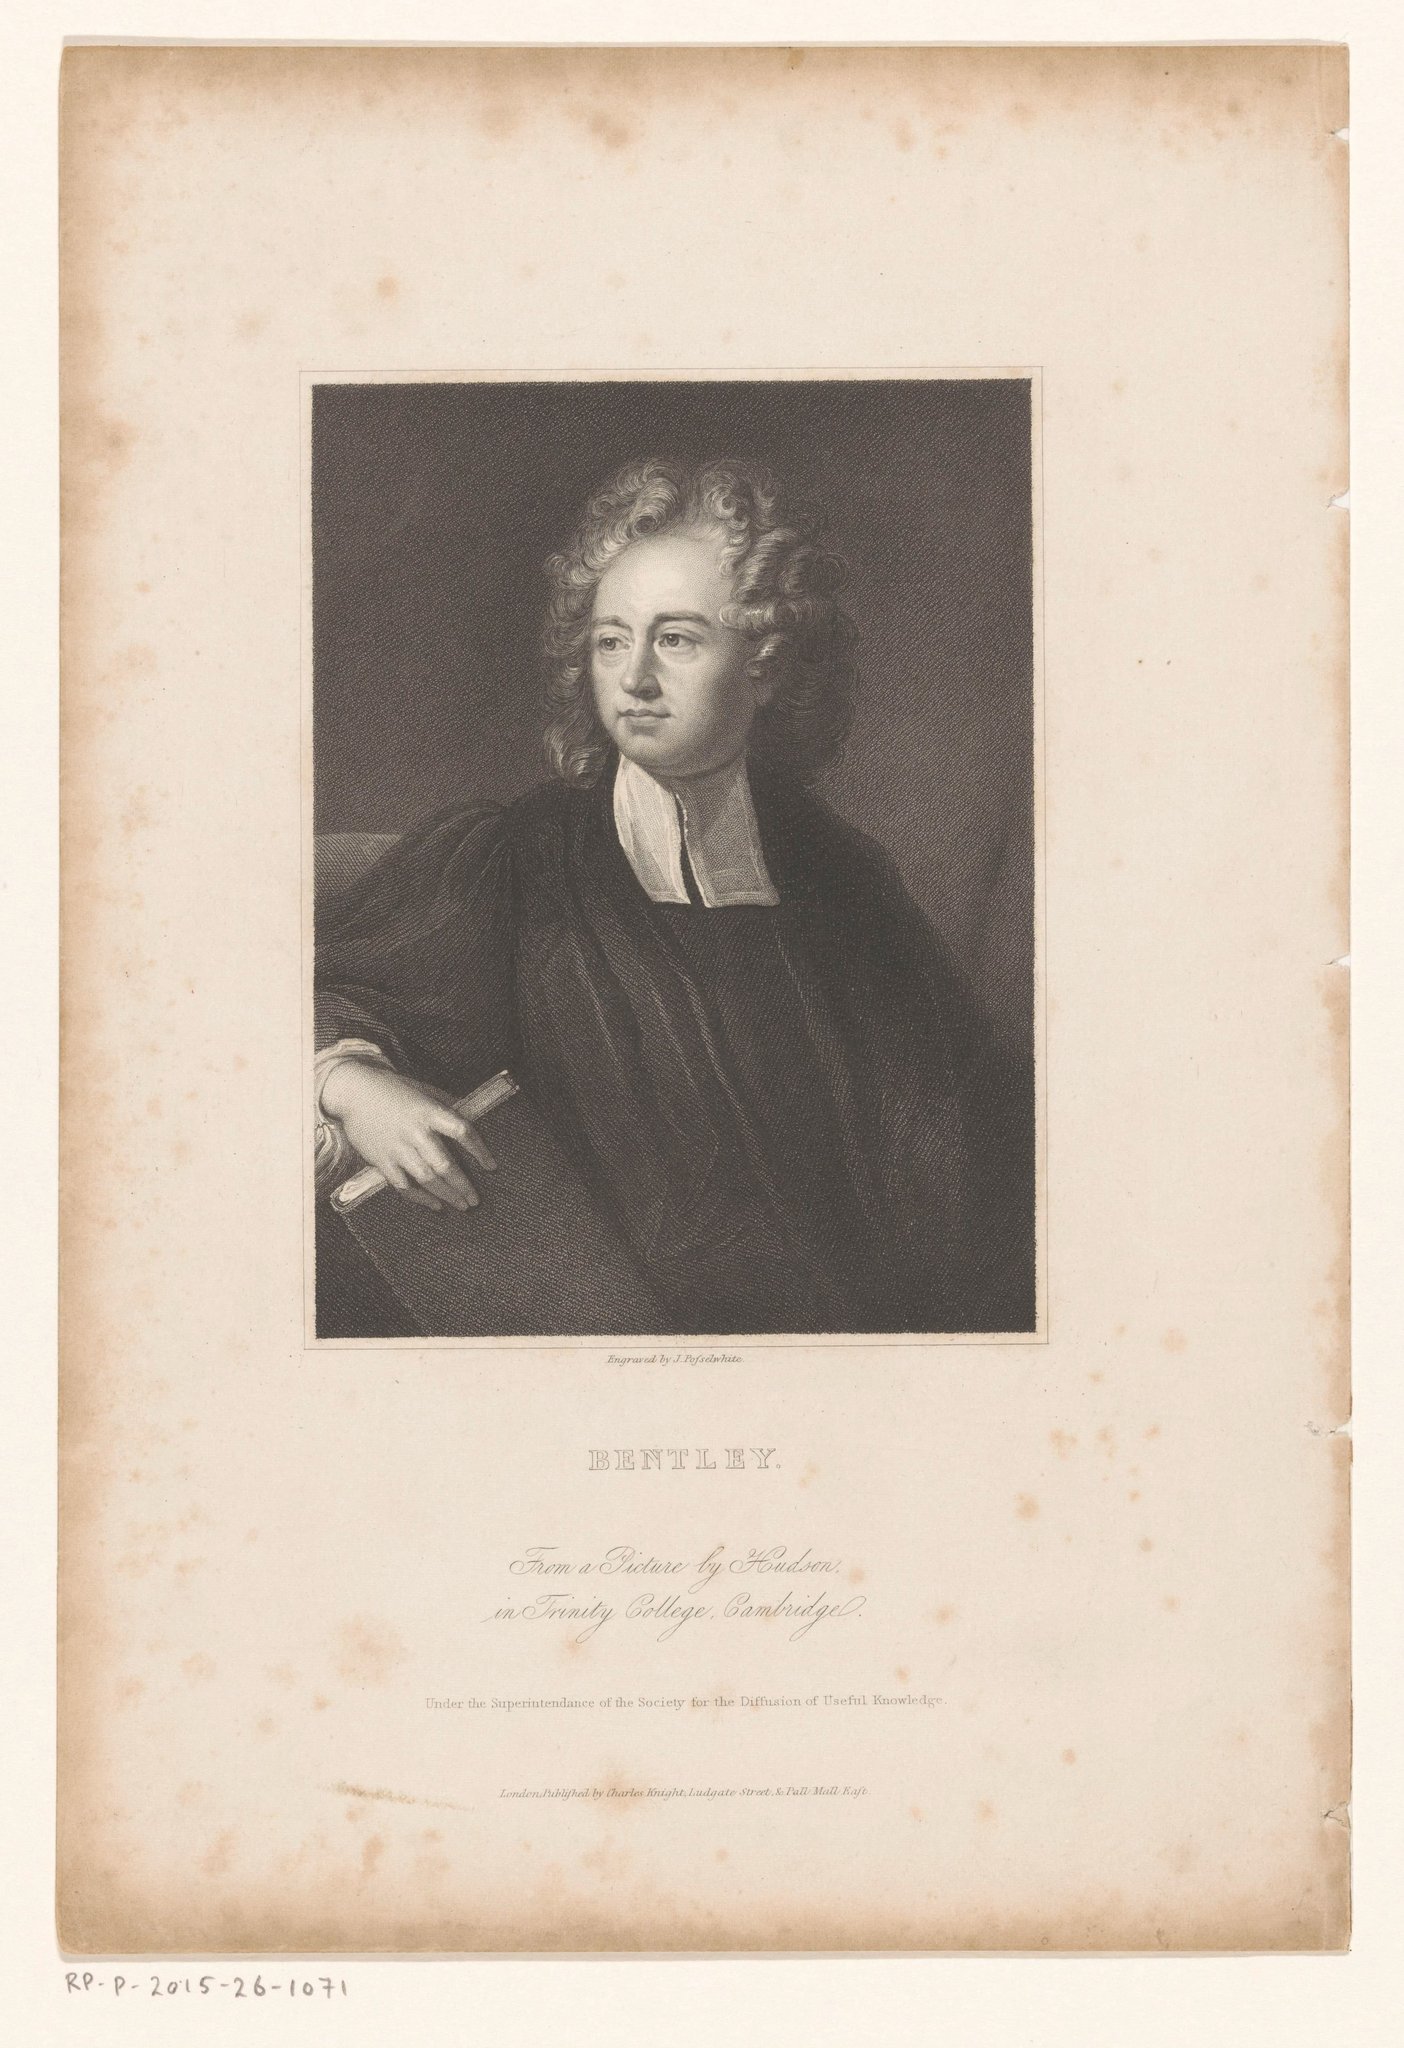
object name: print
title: Bentley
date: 1833-1837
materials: paper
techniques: etching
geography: london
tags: scholar, philosopher, book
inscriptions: collector's mark: Lugt 2228, collector's mark: Lugt 4779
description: Prent ook gebruikt in: [Malkin, Arthur Thomas]. The gallery of portraits: with memoirs. 7 Dln. Londen: Charles Knight, 1833-1837.